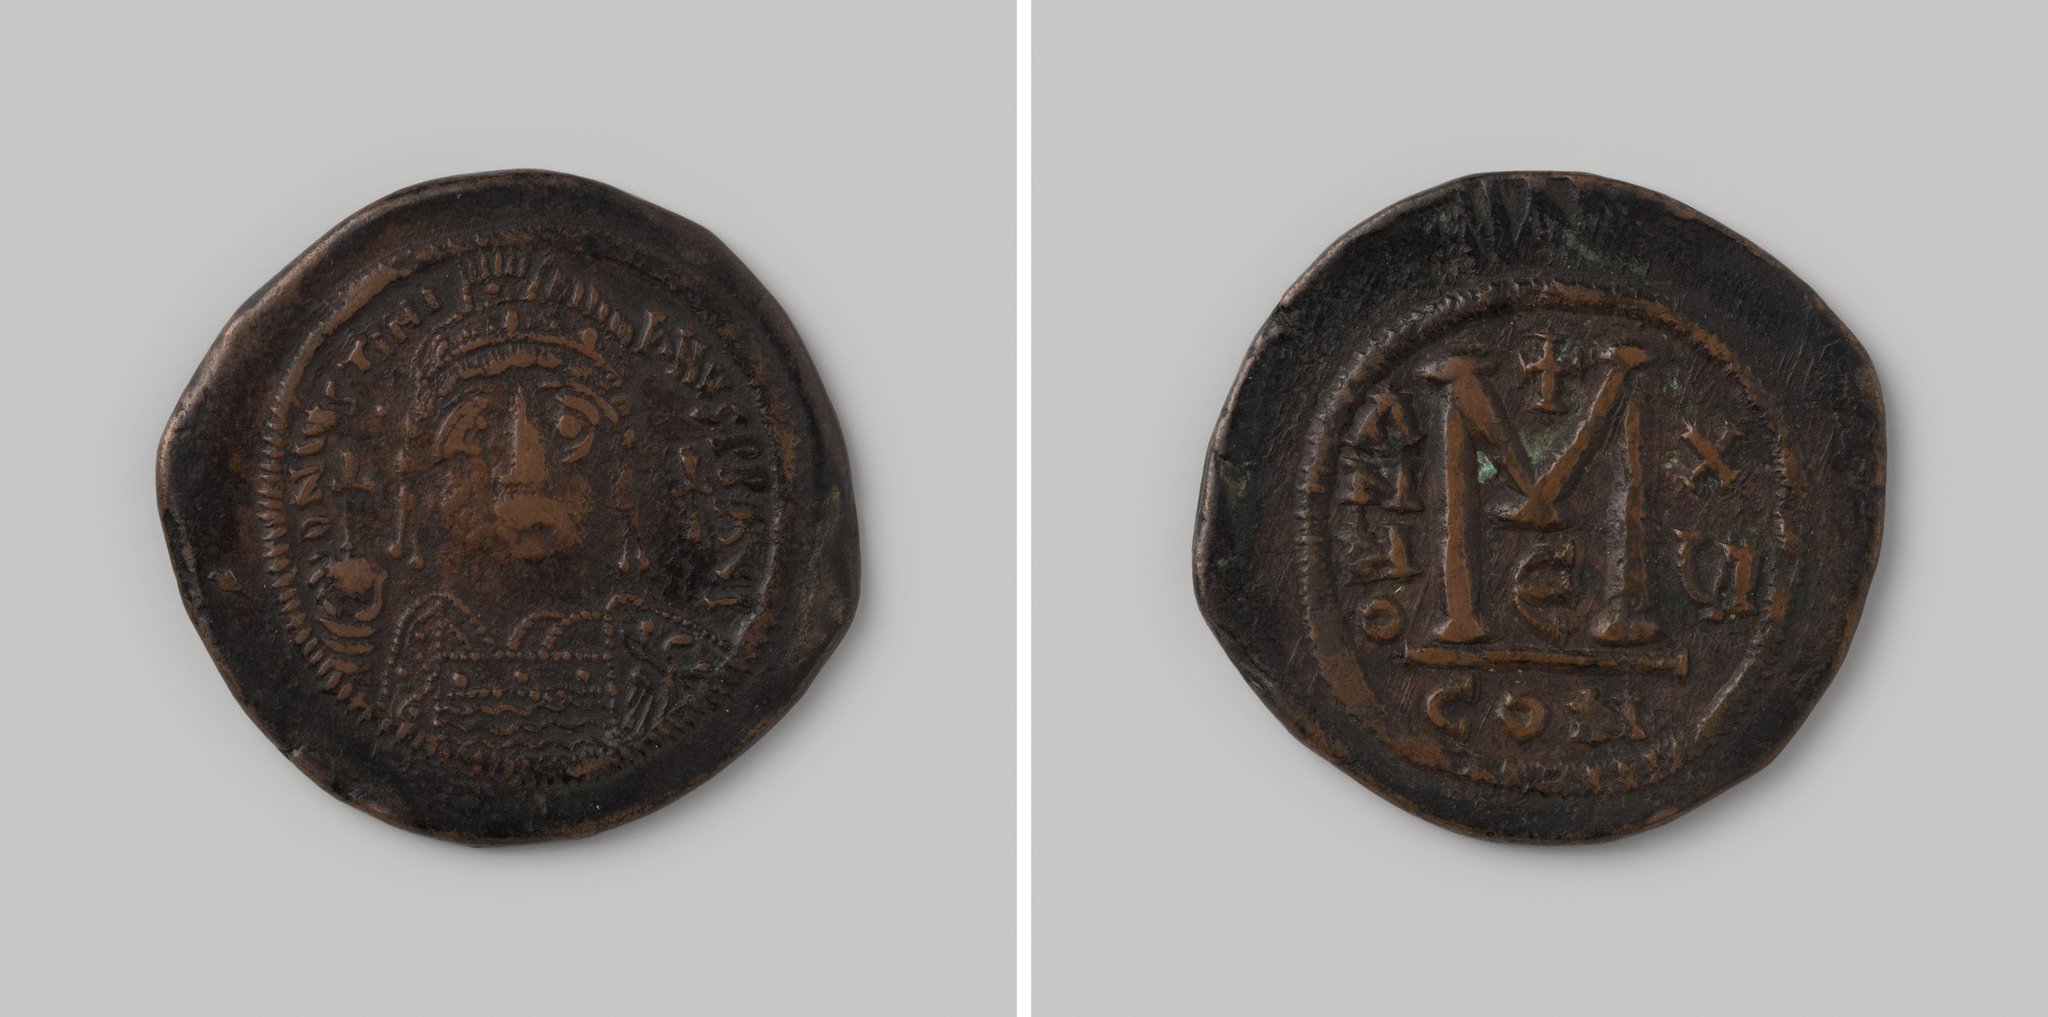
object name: follis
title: Byzantijnse Keizerrijk, follis, Justinianus I, 527-565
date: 542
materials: bronze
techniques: striking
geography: constantinople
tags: macedonië, keizer, justinianus i (keizer van het byzantijnse rijk)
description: Bronzen munt op grote muntplaat. Voorzijde: borstbeeld van de keizer met harnas en diadeem van voren met in de rechterhand hemelbol met kruis. Keerzijde: tussen jaar-aanduiding Anno XV letter M [=40, waarde-aanduiding, 40 nummia] met boven de letter een kruis. In de afsnede de letters CON [=Constantinopel].